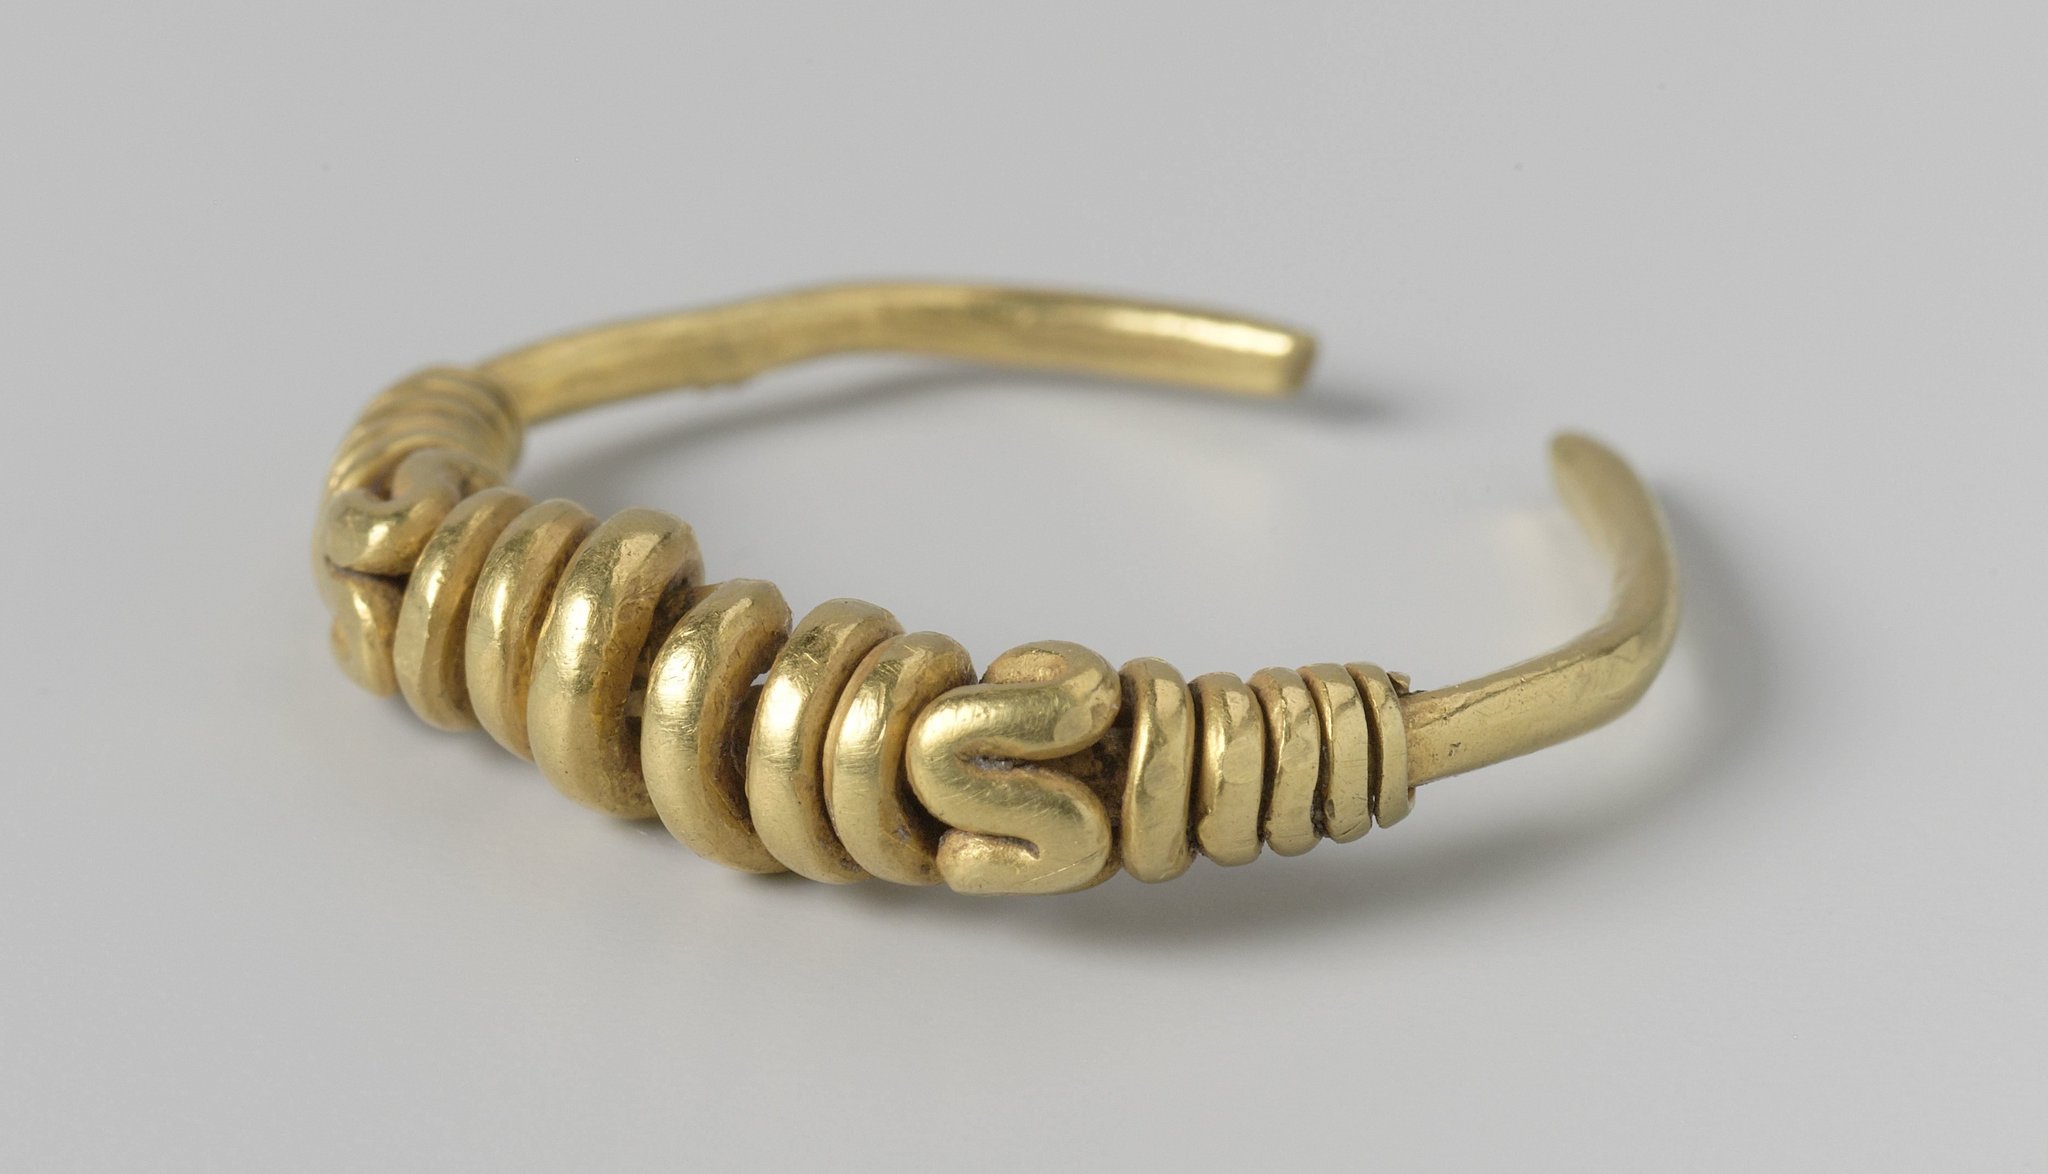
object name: jewellery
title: Ring van gewonden gouddraad.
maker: Anonymous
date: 300-600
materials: gold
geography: java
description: Ring samengesteld uit gewonden gouddraad